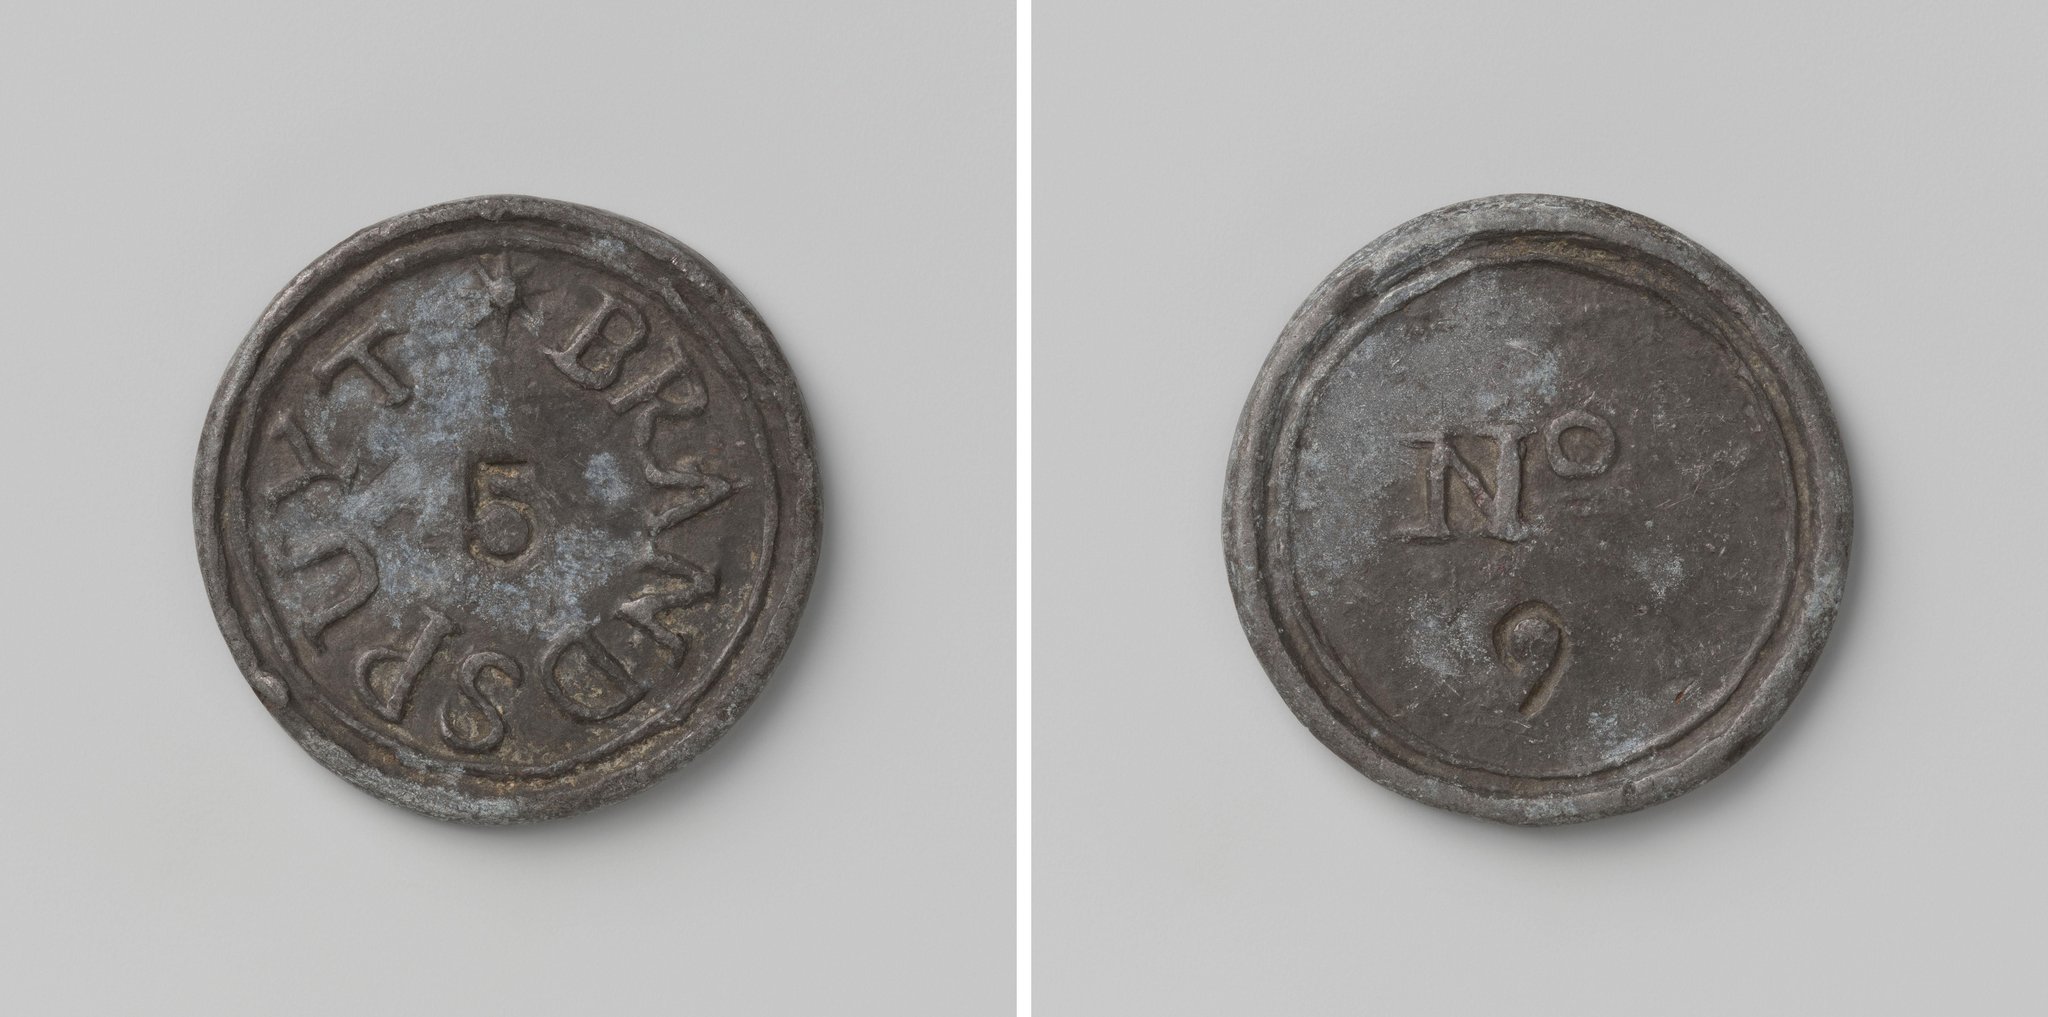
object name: medal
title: Onbekende plaats, brandspuitpenning van spuit 5 met no. 9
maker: Anonymous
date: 1680-1800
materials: lead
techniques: casting, engraving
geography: netherlands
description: Loden penning. Voorzijde: cijfer 5 binnen omschrift. Keerzijde: cijfer N. 9